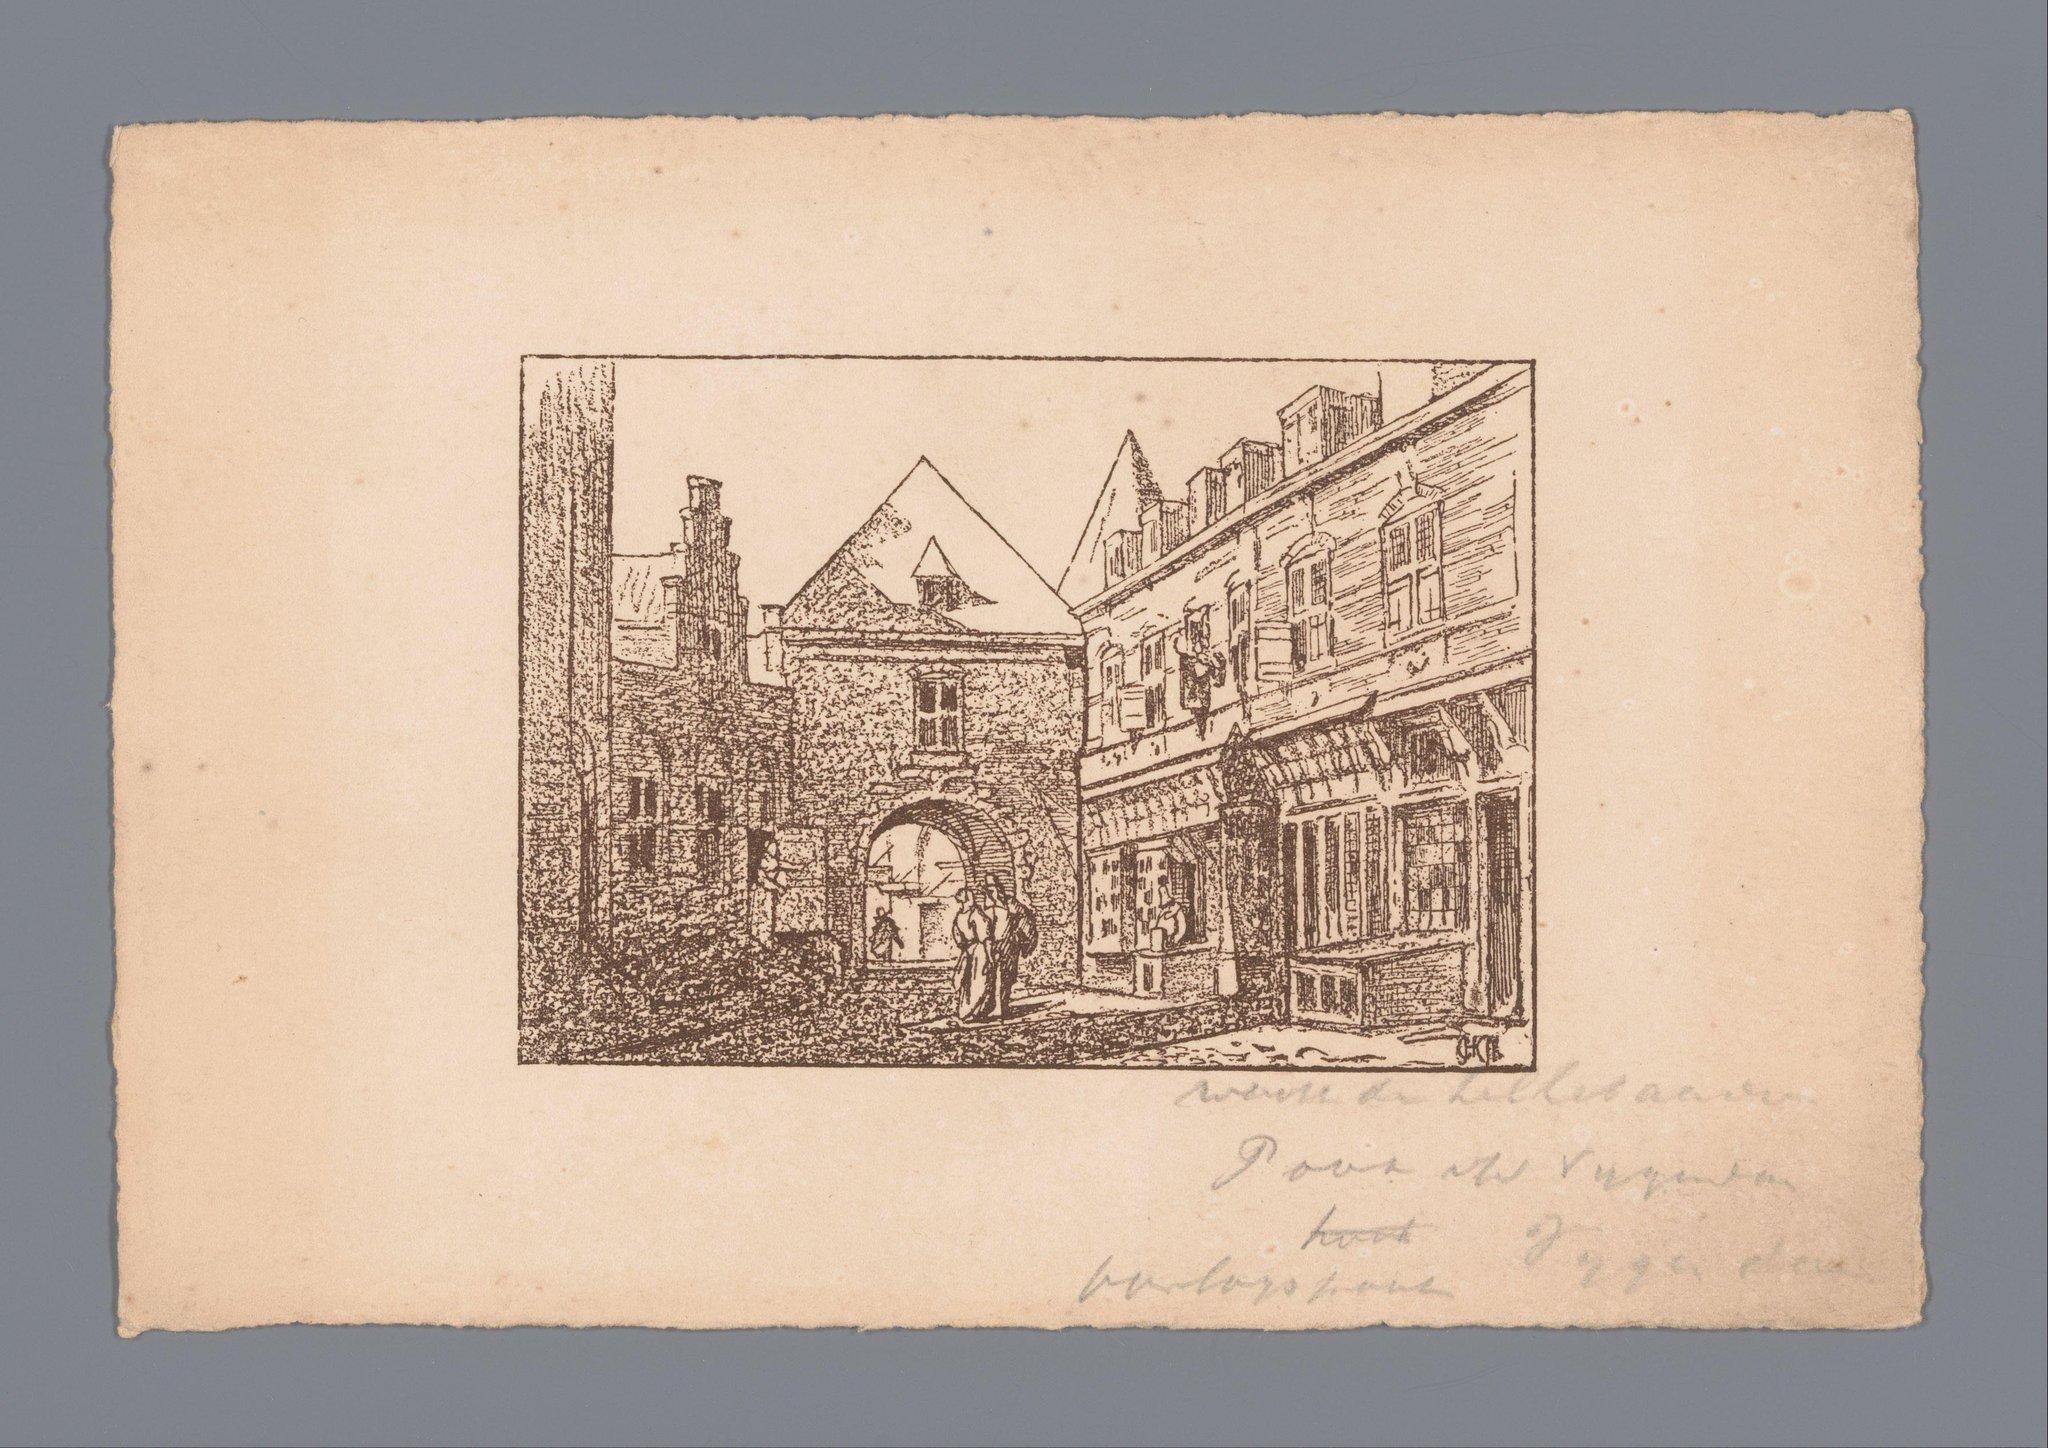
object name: print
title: Stadsgezicht met winkelpanden en een poort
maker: Anonymous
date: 1800-1899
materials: paper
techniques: lithograph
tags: private soldier (+ infantry), civic architecture; edifices; dwellings, amsterdam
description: Historisch stadsgezicht in de zestiende of zeventiende eeuw. Rechtsonder gemonogrammeerd JCKH of CJKH.